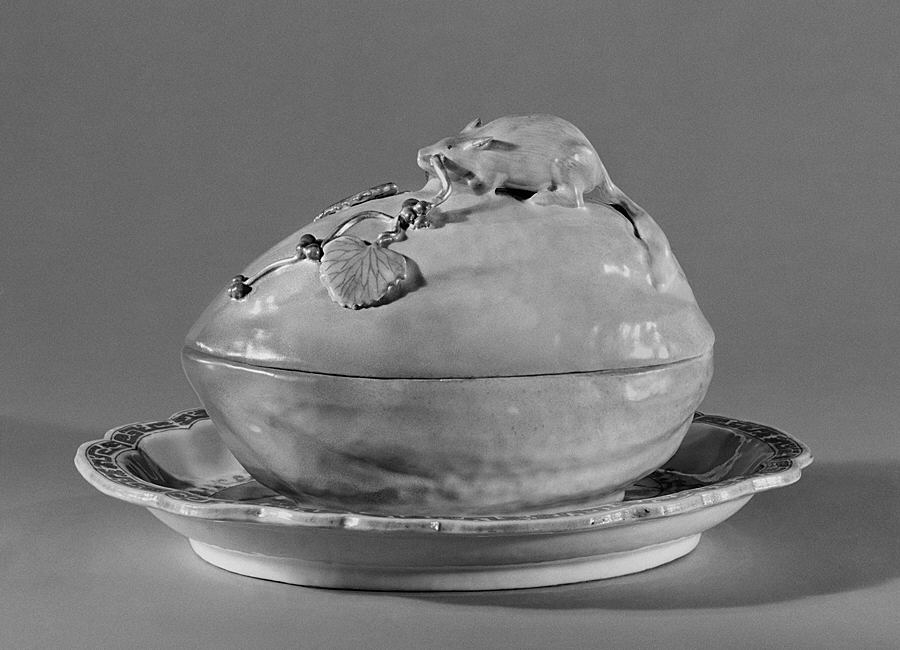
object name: tureen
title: Tureen in the shape of a mellon with a squirrel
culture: chinese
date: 1801-1900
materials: enamel, porcelain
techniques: overglaze, painting, polychrome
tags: squirrels